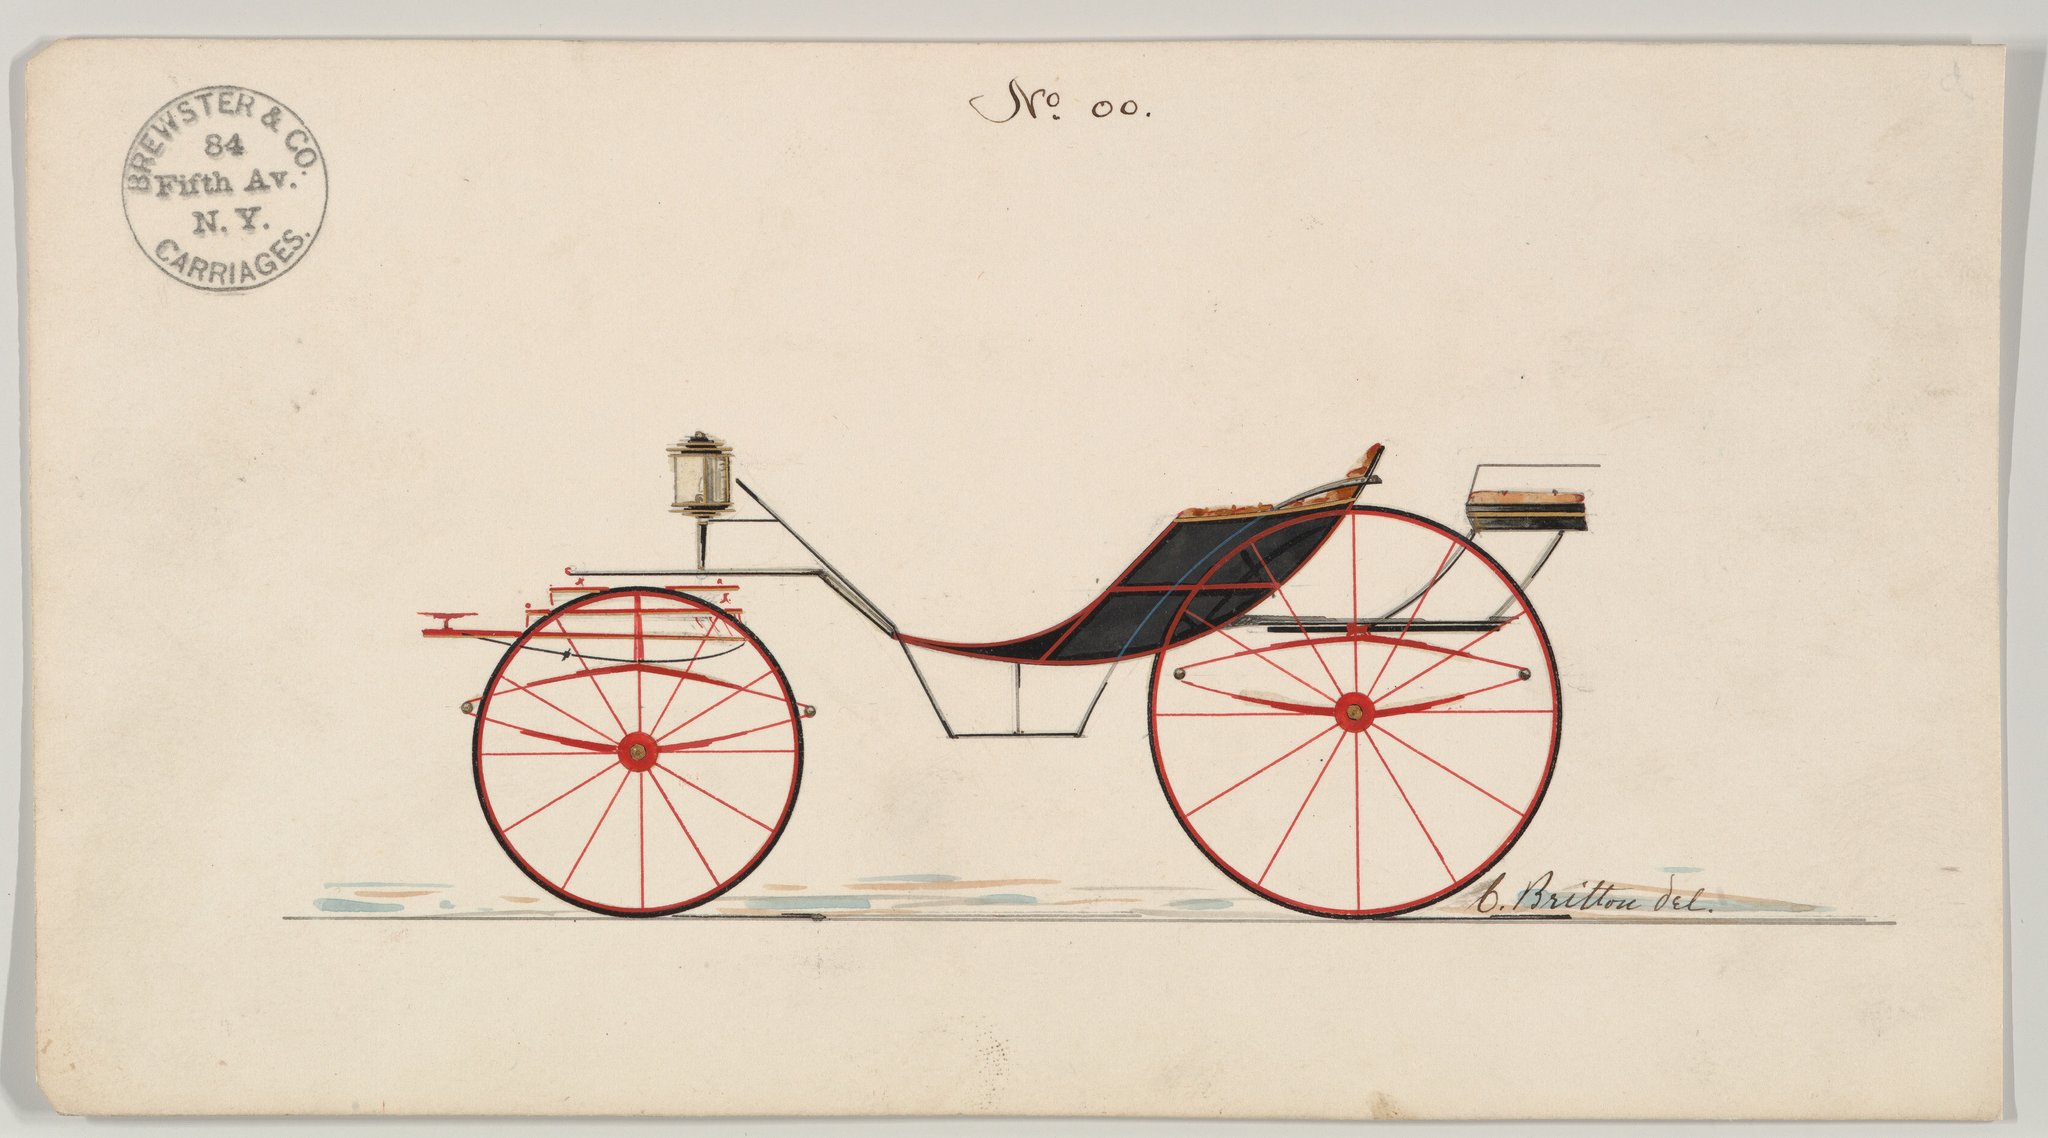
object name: drawing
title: George IV Phaeton #00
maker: brewster & co.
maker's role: manufacturer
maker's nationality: american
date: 1865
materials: gouache, gum arabic, ink, watercolor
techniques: pen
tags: carriages